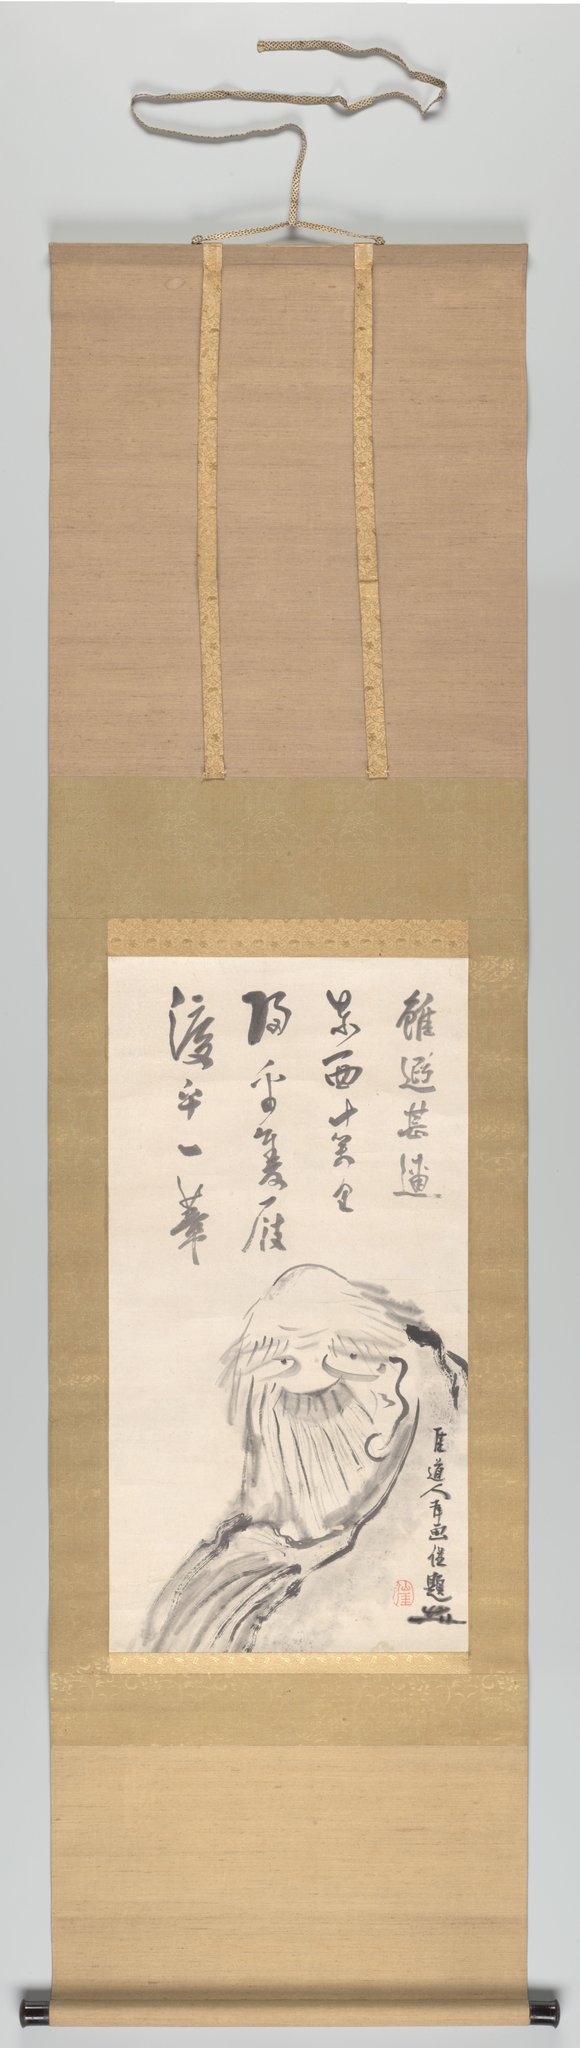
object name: hanging scroll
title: Daruma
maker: sengai gibon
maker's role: painter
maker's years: 1750-1837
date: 1750-1837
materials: ink, paper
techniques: calligraphy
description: According to tradition, the monk Daruma transmitted Zen teaching to China. He is said to have meditated for nine years, his face turned towards the wall. Such portraits served as objects of devotion, reminding the Zen pupil of Buddhist doctrines. Sengai imbues Daruma with a sense of humanity and gentle humour, and an inquisitive sternness is reflected in his wise gaze.